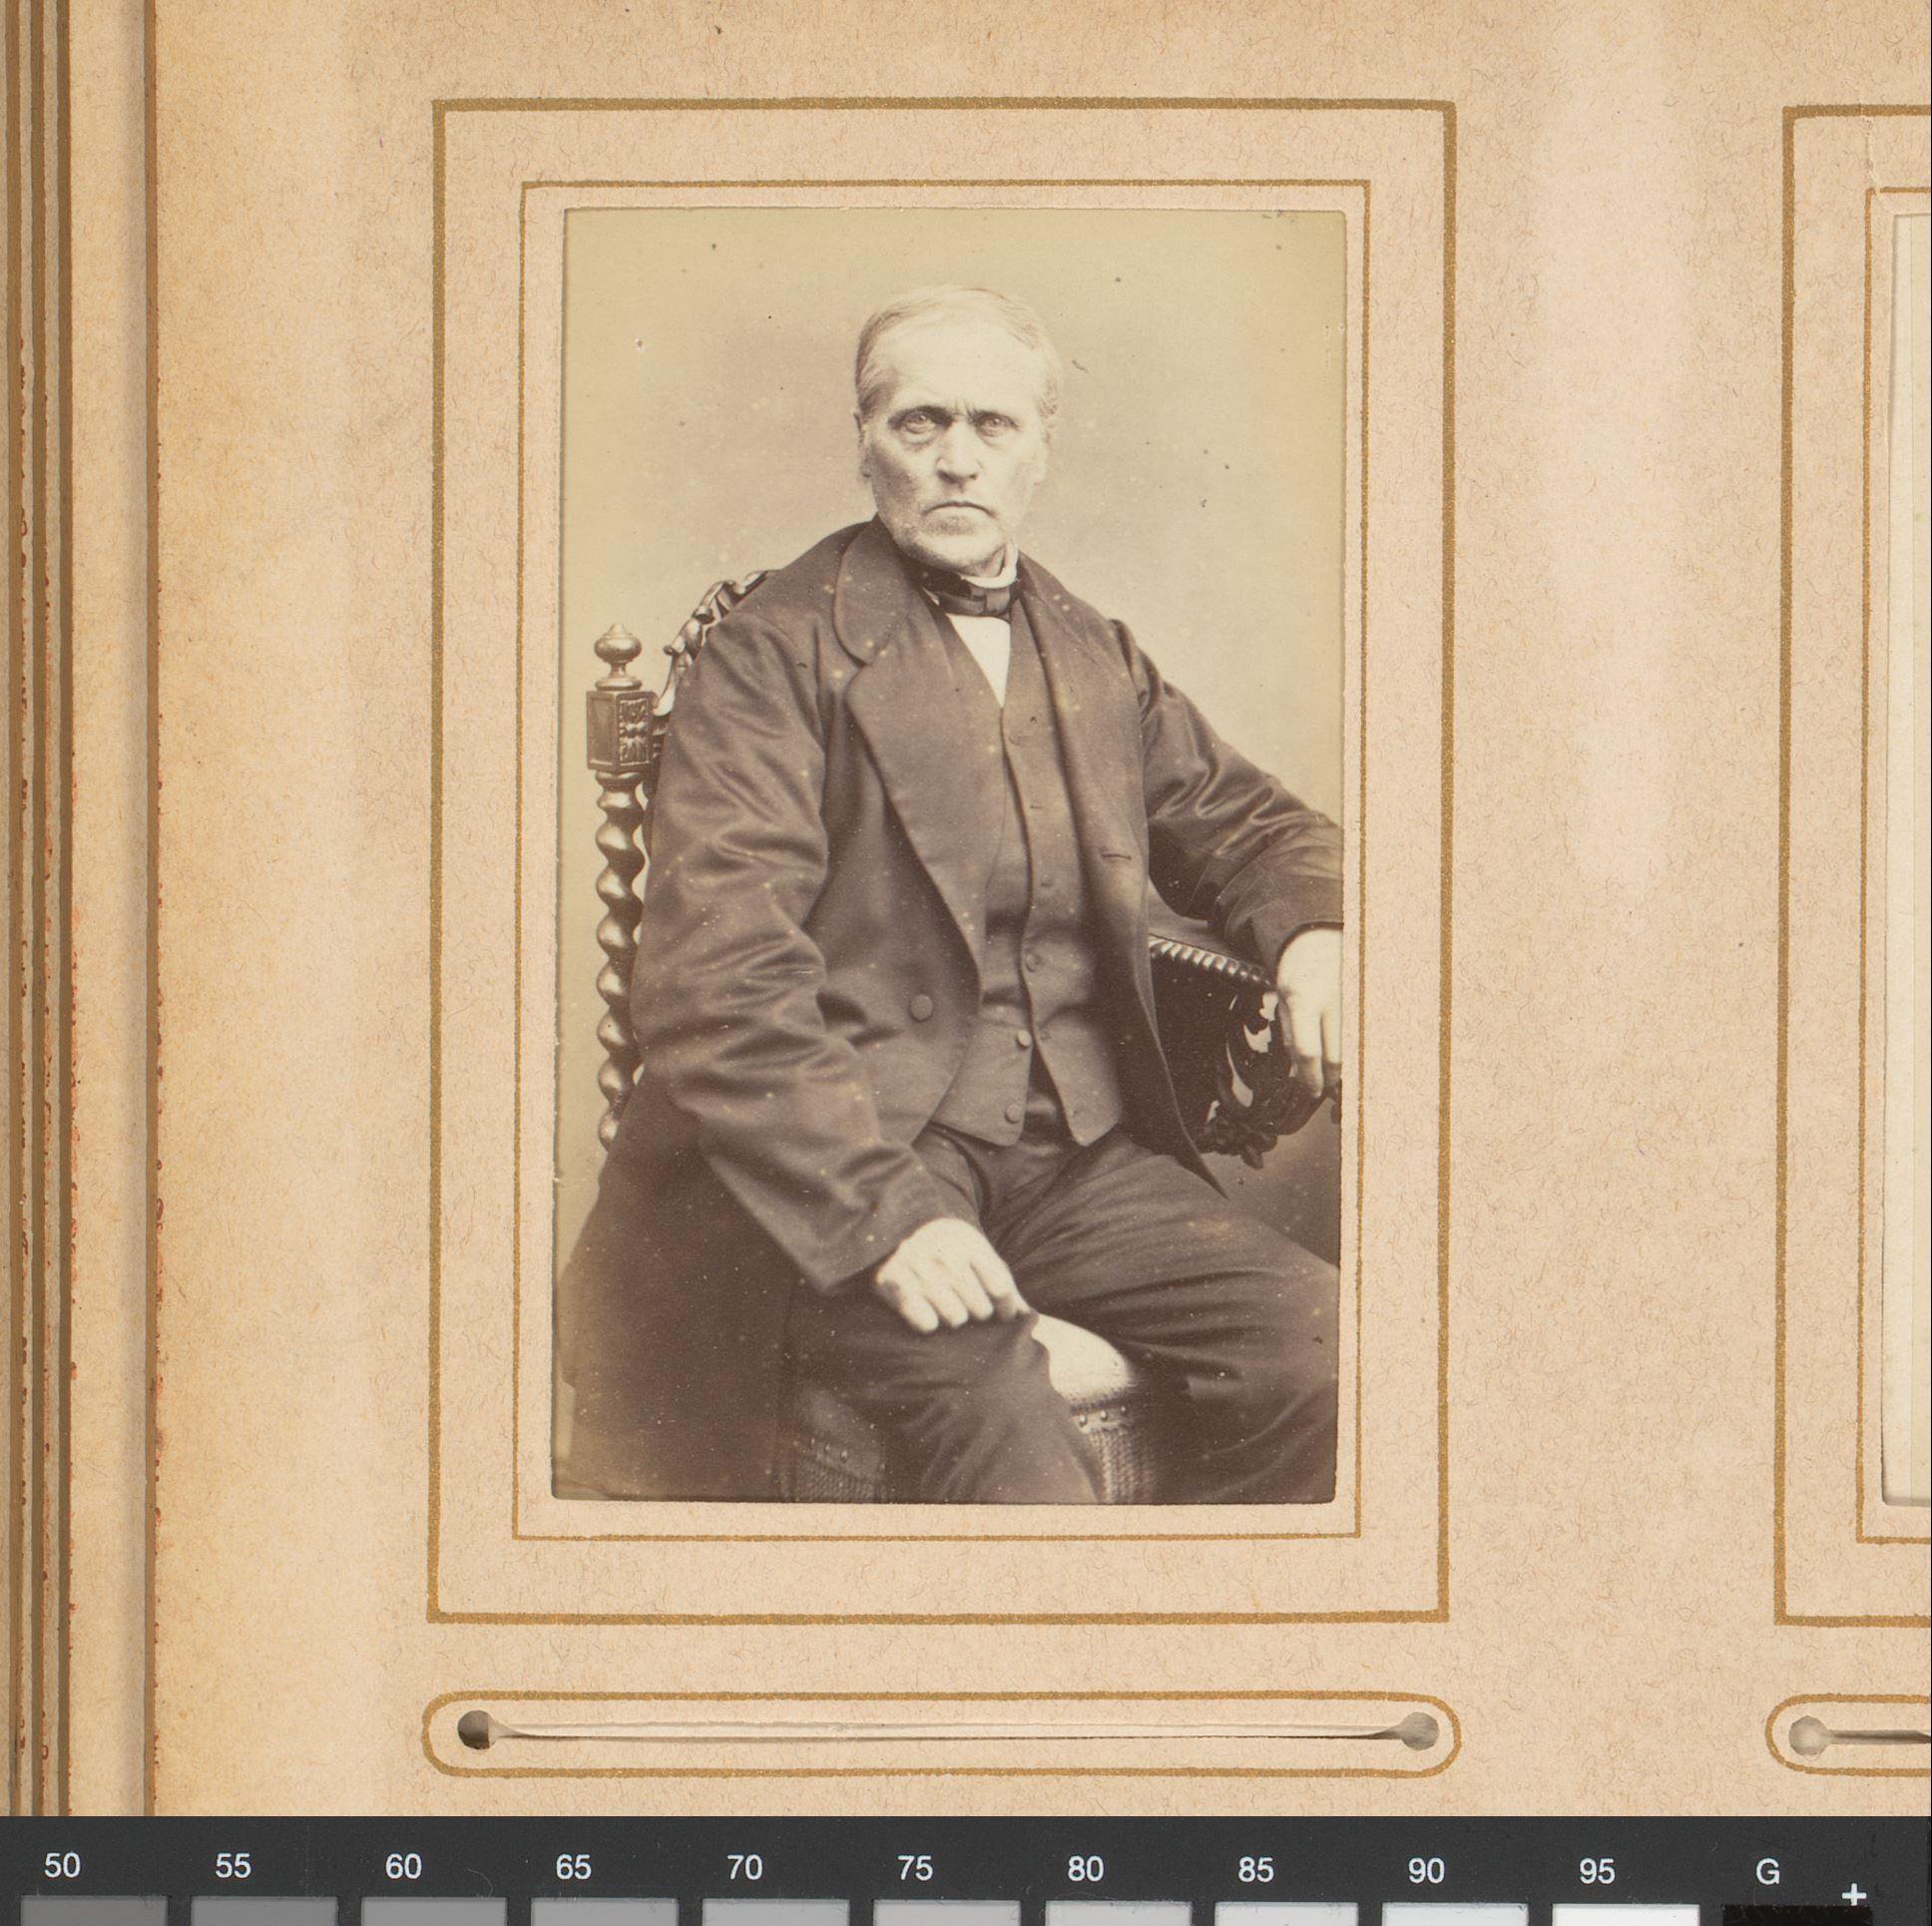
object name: photograph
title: Portret van een zittende oude man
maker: albert greiner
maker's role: fotograaf, fotostudio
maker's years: 1833-1890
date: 1861-1874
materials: cardboard, photographic support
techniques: albumen print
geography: amsterdam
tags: sitting figure, historical persons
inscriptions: inscription: ‘A. Greiner/ Photograf/ Nieuwendijk L.87/ Amsterdam’